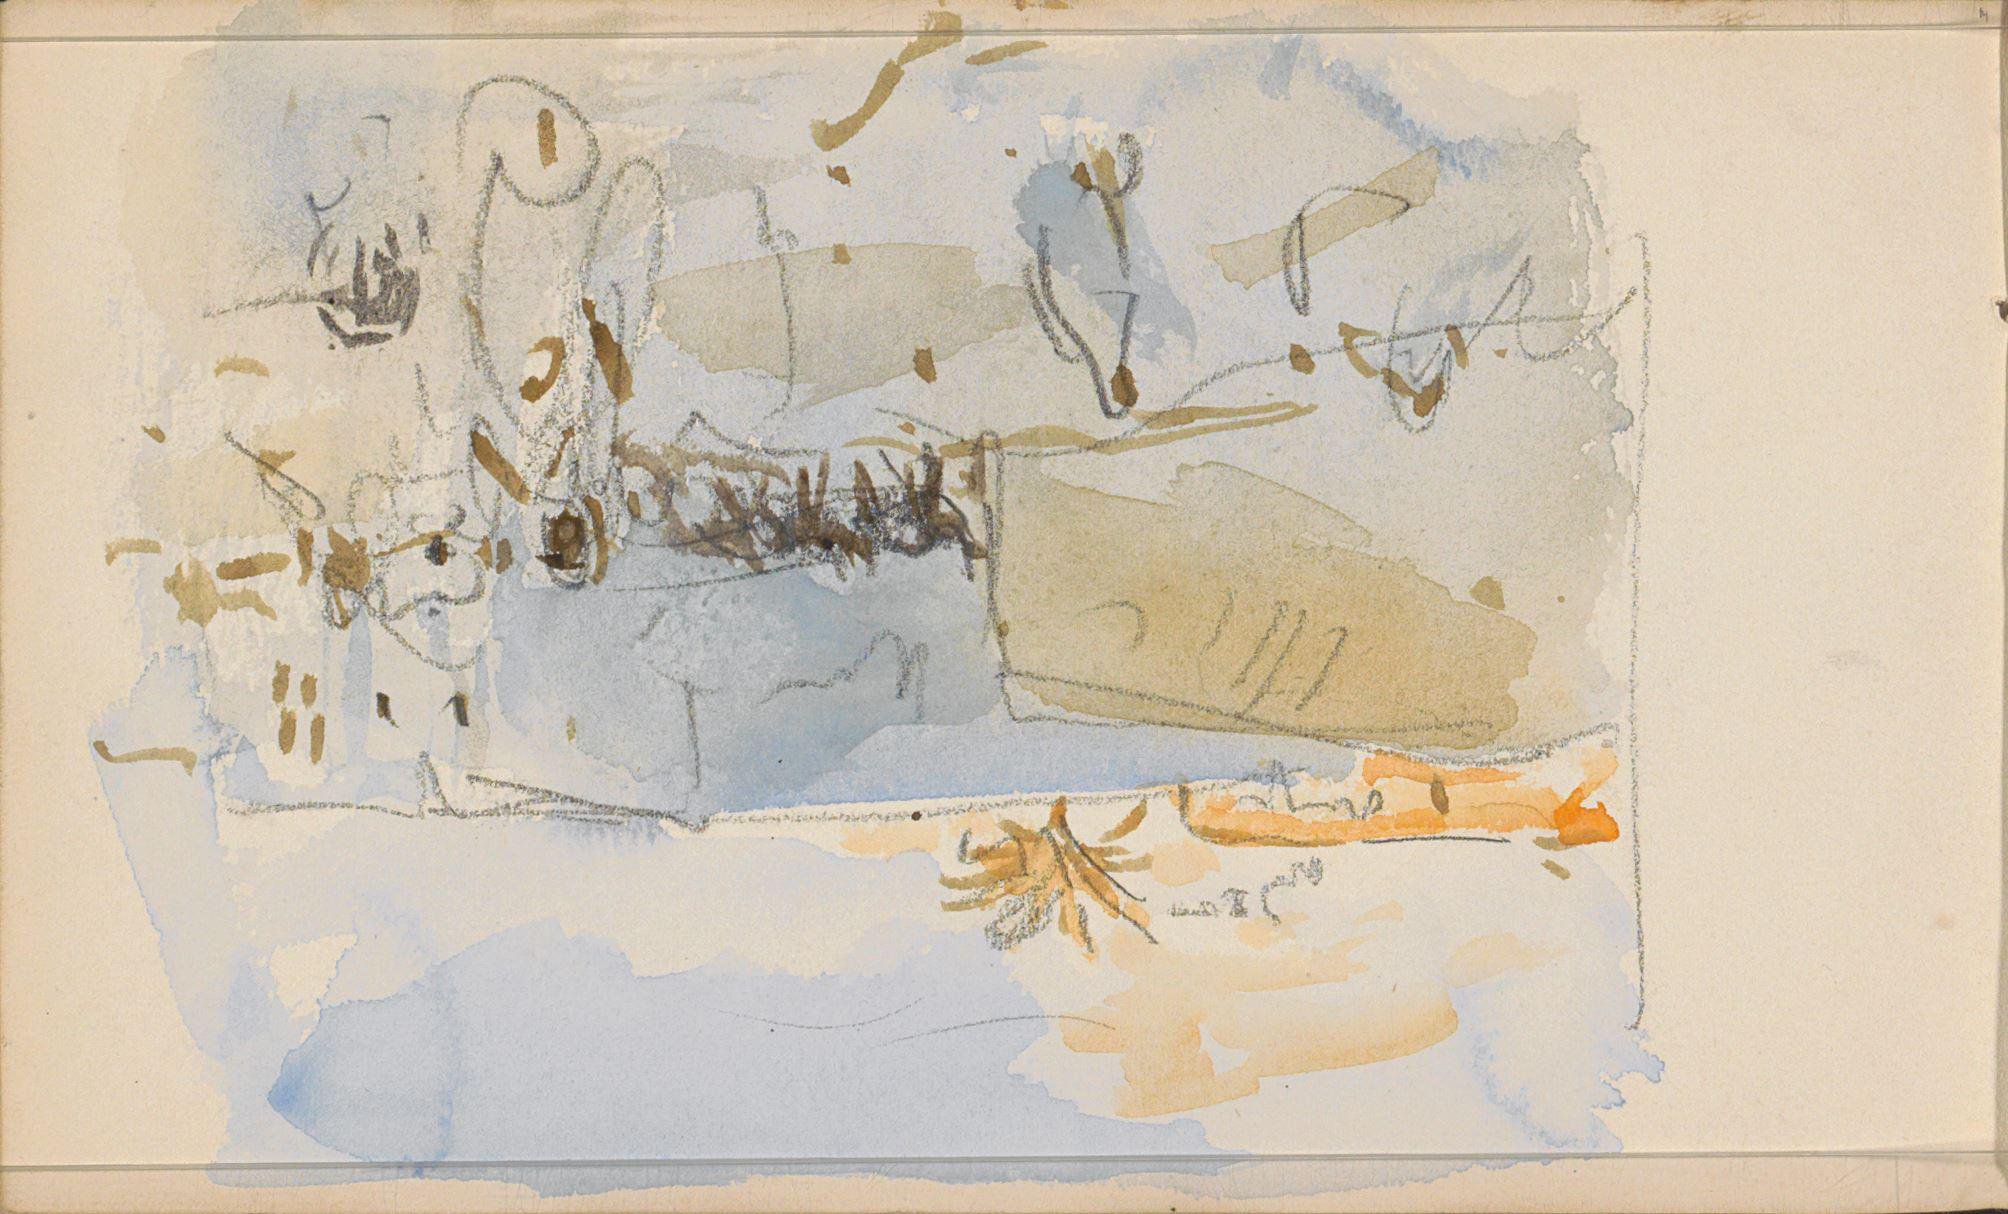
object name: sketchbook leaf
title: Straat met figuren in Biskra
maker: marius bauer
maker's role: draughtsman, print maker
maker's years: 1867-1932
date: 1922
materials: paper, pencil, watercolor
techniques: brush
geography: biskra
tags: street (+ city(-scape) with figures, staffage)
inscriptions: kleurnotitie, handgeschreven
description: Pagina 14 uit een schetsboek met 31 bladen.